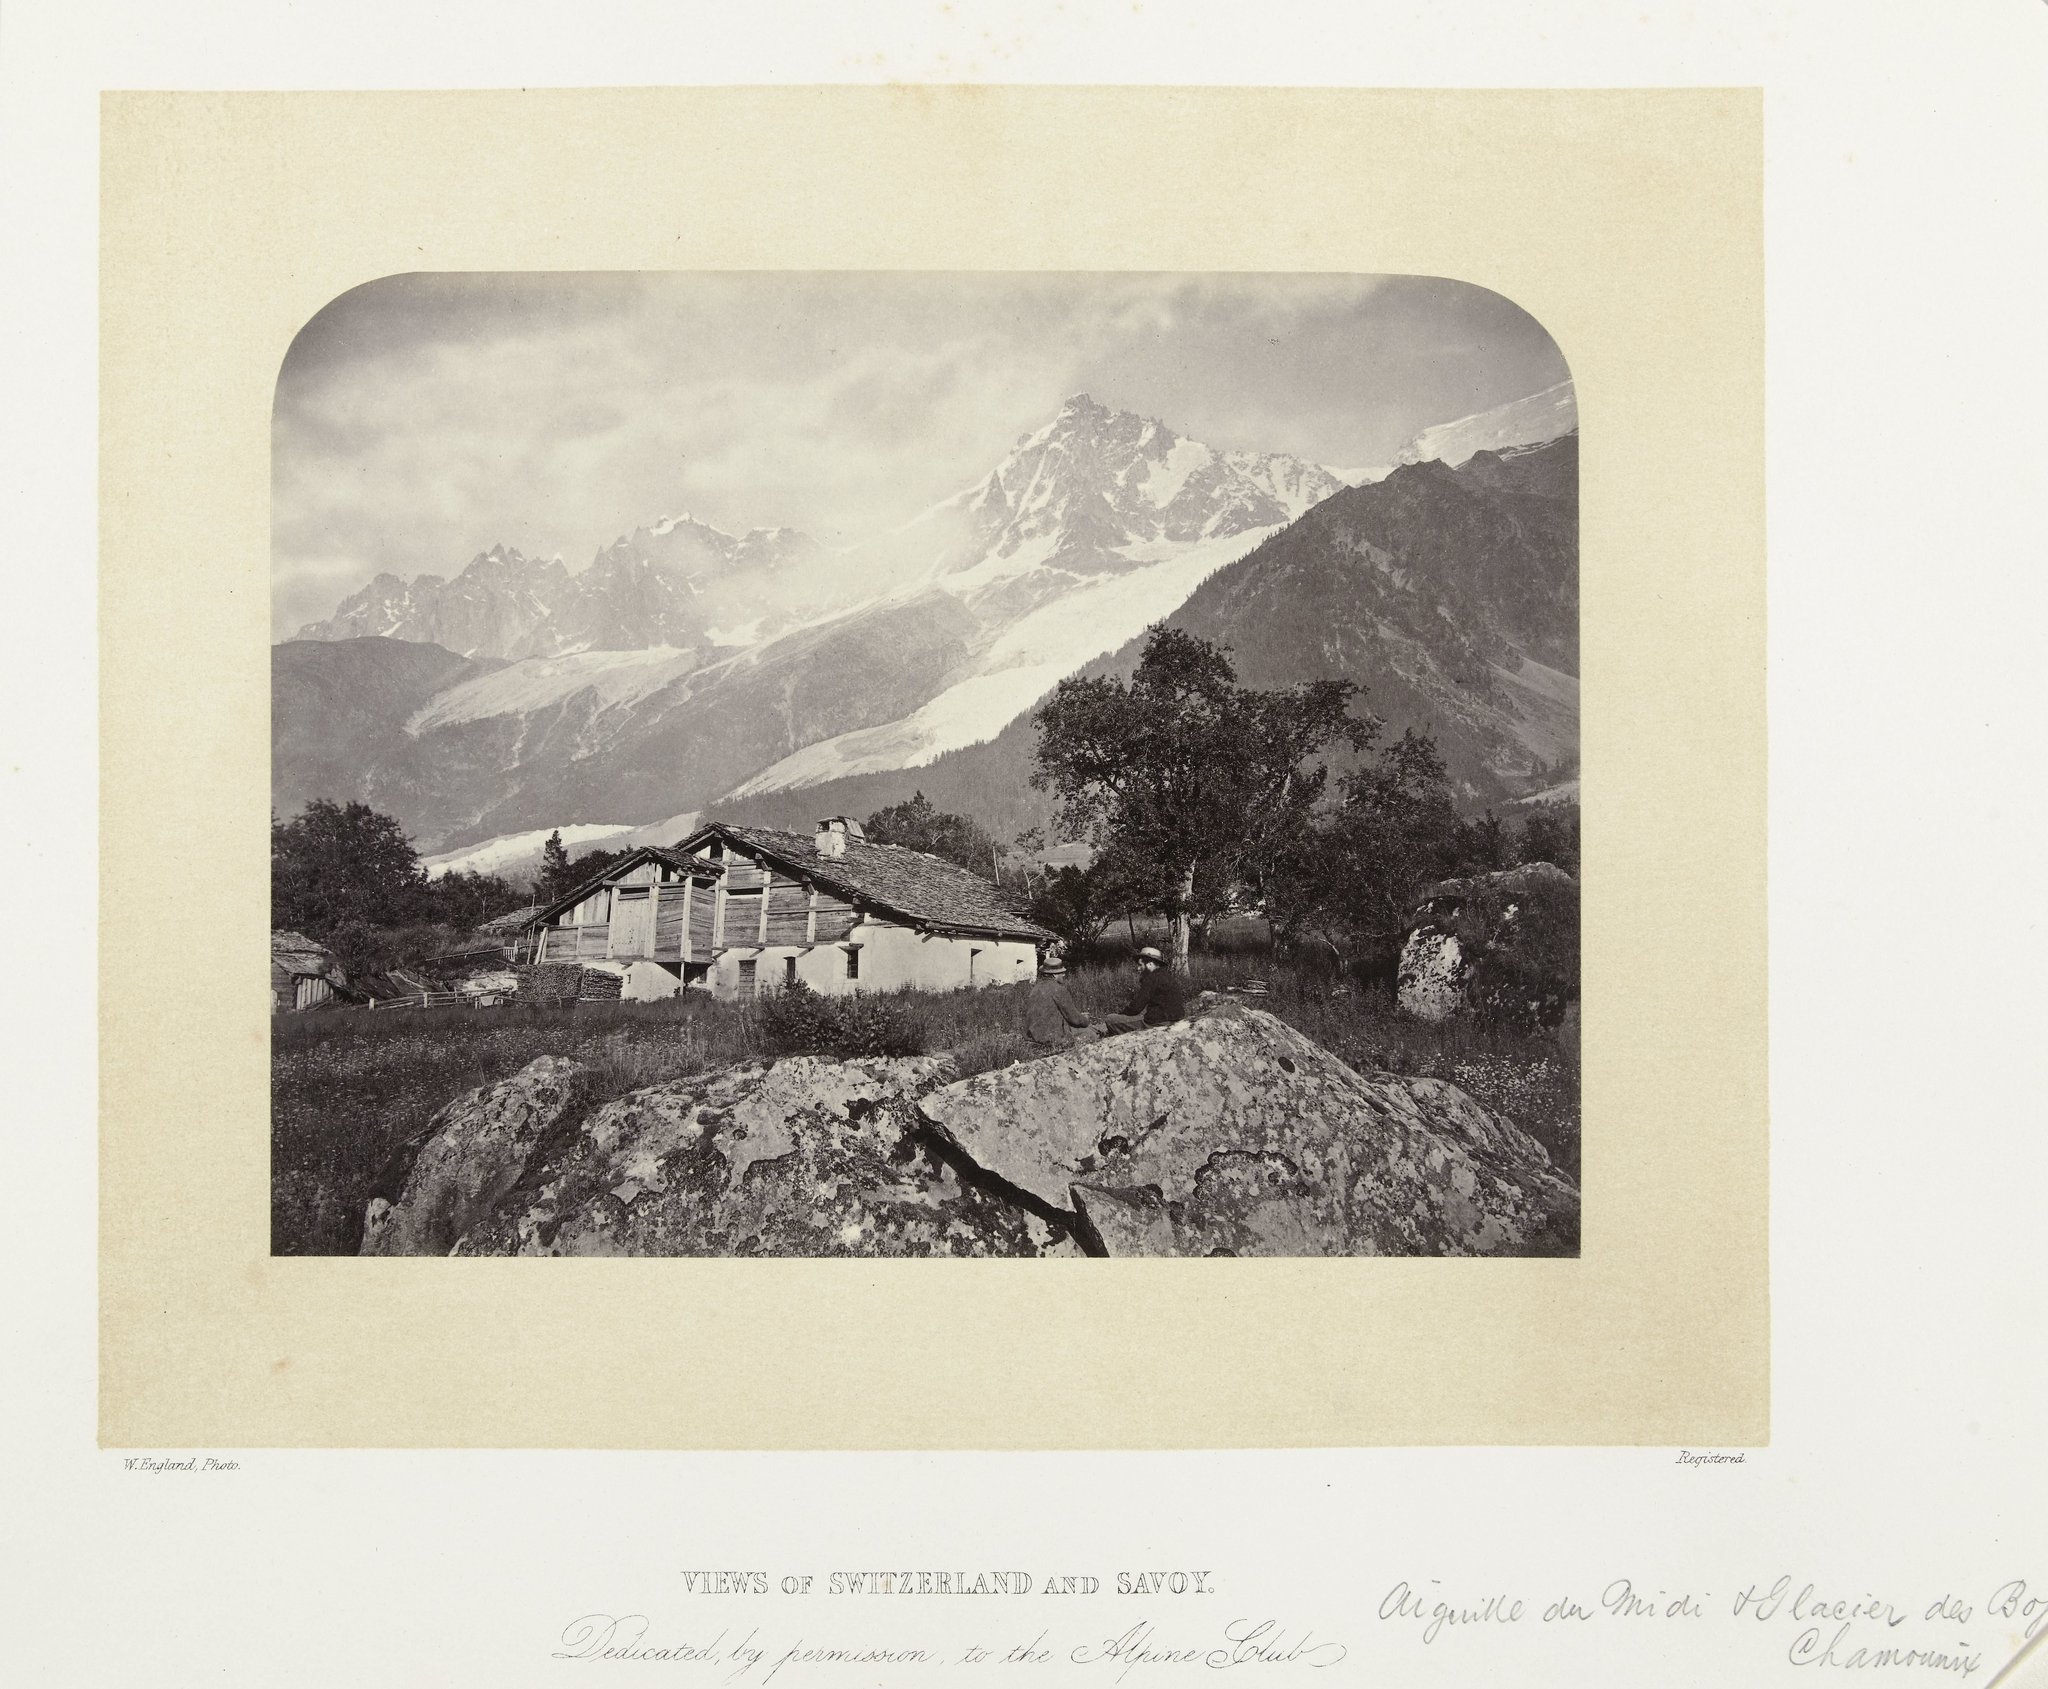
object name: photograph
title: Gezicht op de Aiguille du Midi en de Bossons-gletsjer, op de voorgrond een huis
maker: william england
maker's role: fotograaf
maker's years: 1816-1896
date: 1863-1865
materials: cardboard, paper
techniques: albumen print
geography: london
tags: glacier, mountains, bossons glacier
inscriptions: address: ‘Messrs Marion & Co 22 & 23 Soho Square, London W.’, inscription: ‘Registered’, inscription: ‘Dedicated, by permission, to the Alpine Club’